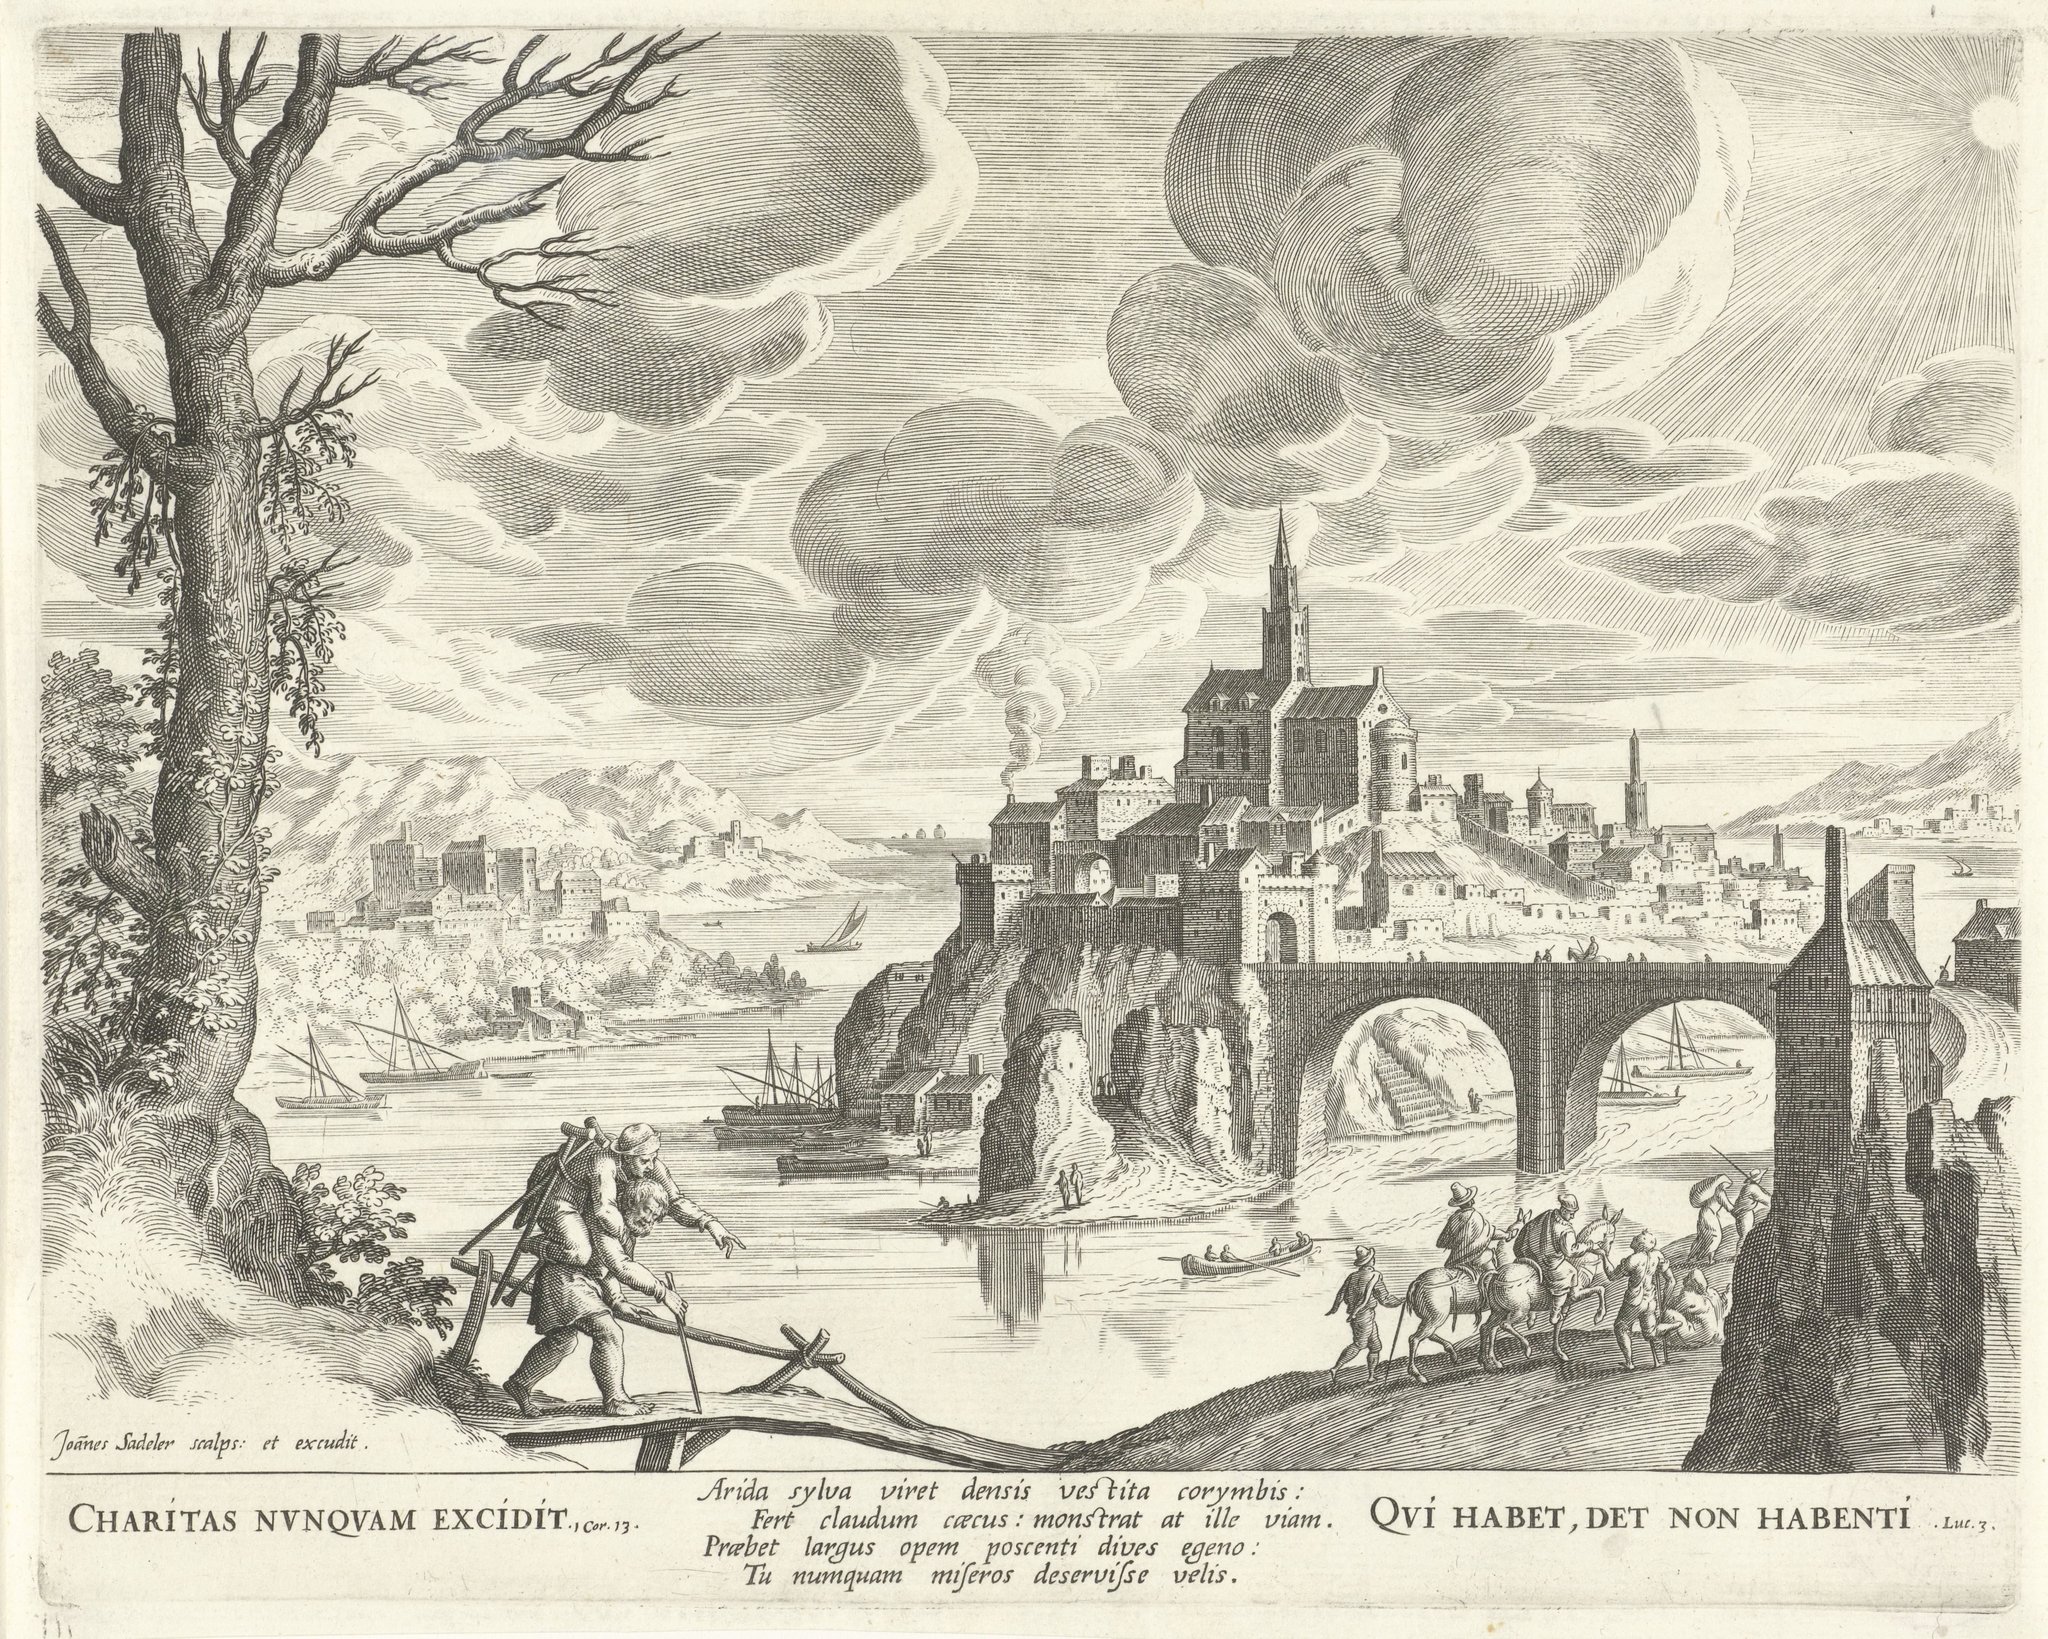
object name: print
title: Landschap met een verlamde man die een blinde man over een brug leidt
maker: johann sadeler (i)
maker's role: print maker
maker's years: 1550-1600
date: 1560-1600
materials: paper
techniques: engraving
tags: proverbs, sayings, etc., river (+ landscape with figures, staffage)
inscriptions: collector's mark: Lugt 240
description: Een verlamde man zit op de rug van de blinde man die over een smalle brug loopt langs een brede rivier. Hij leidt hem de weg. Op de achtergrond gezicht op een stad met grote kerk en een brug. Tekst in het Latijn over barmhartigheid in de ondermarge, verwijzend naar Lucas 3.